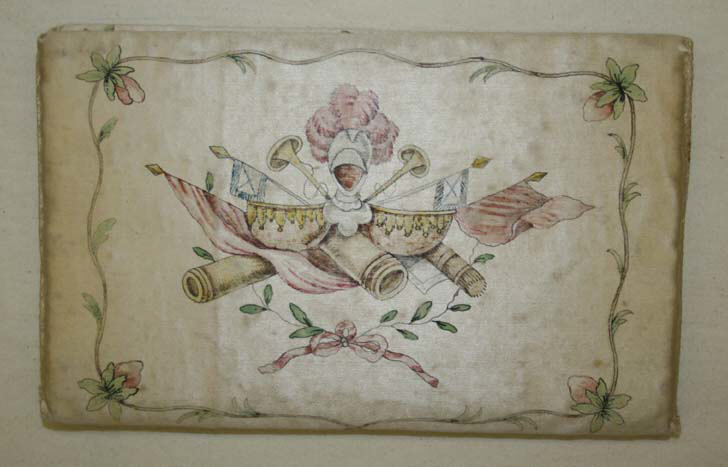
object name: purse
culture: french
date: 1801-1833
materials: silk